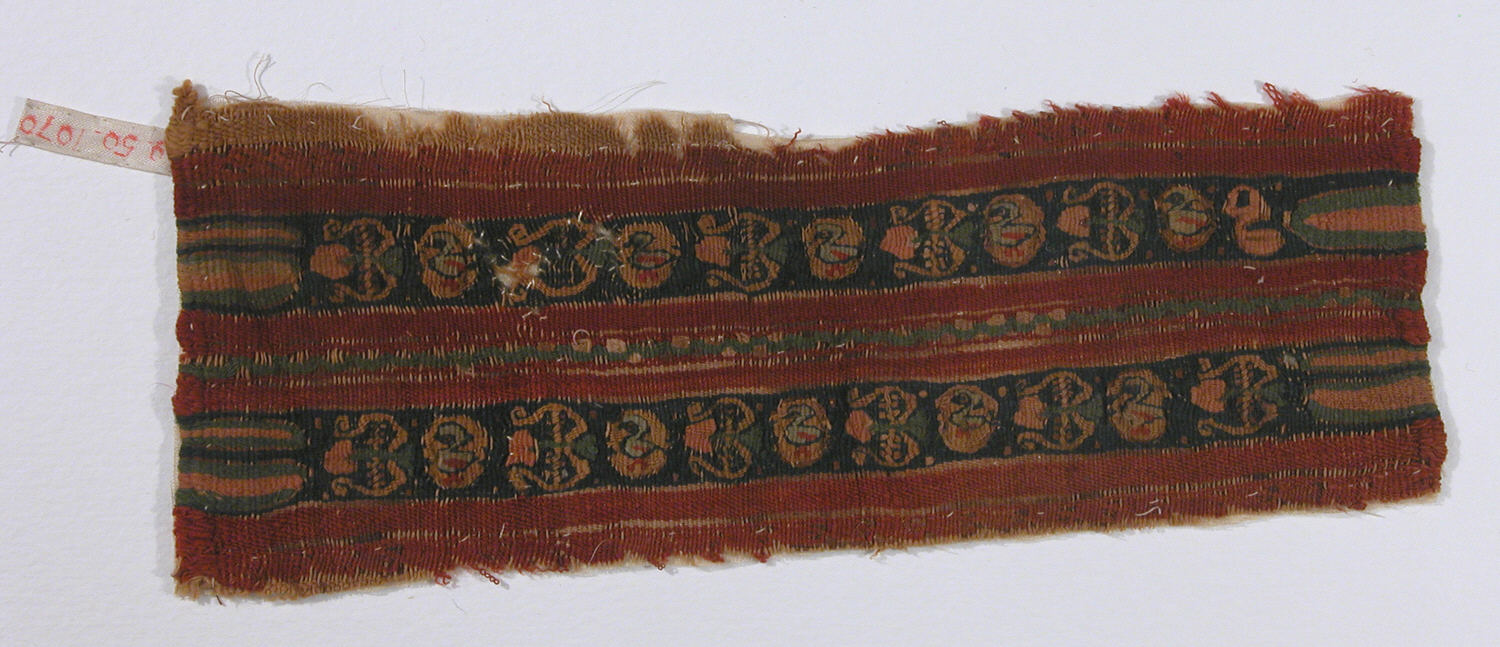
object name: band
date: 401-600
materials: wool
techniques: weave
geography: egypt